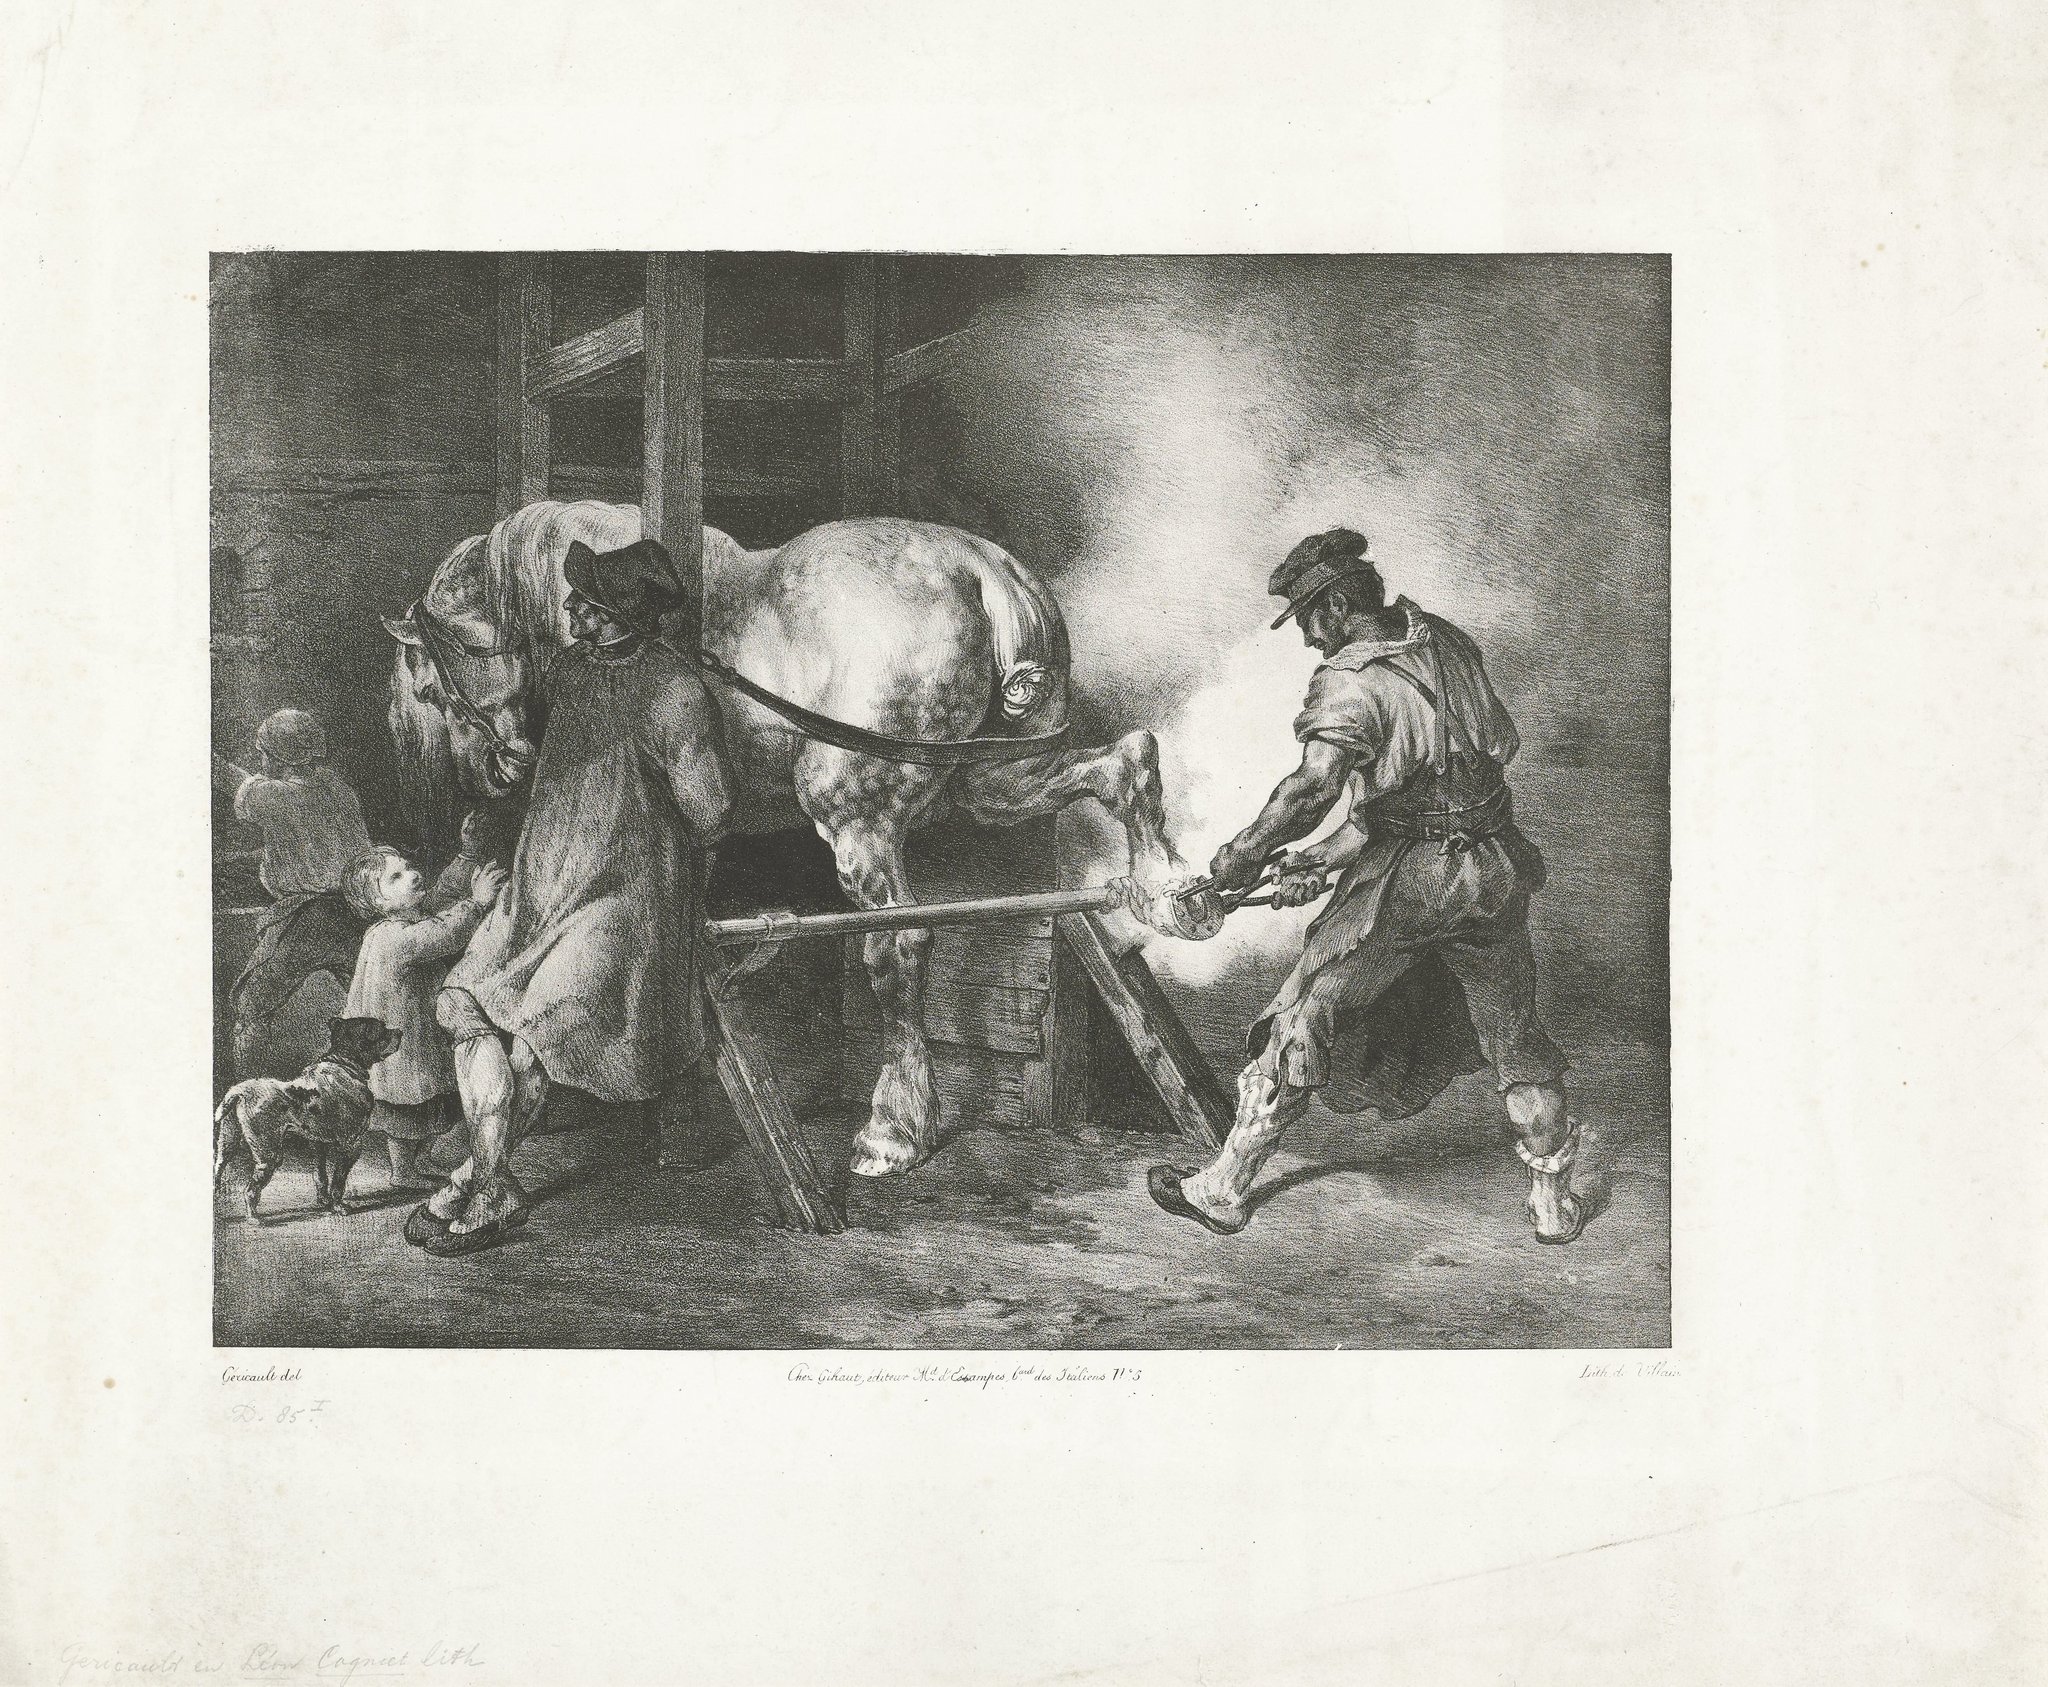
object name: print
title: Etudes de chevaux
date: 1822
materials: paper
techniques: lithograph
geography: paris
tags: farrier, shoeing-smith, horse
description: Een hoefsmid plaatst een heet ijzer op de hoef van een trekpaard. Uit een serie van twaalf prenten.